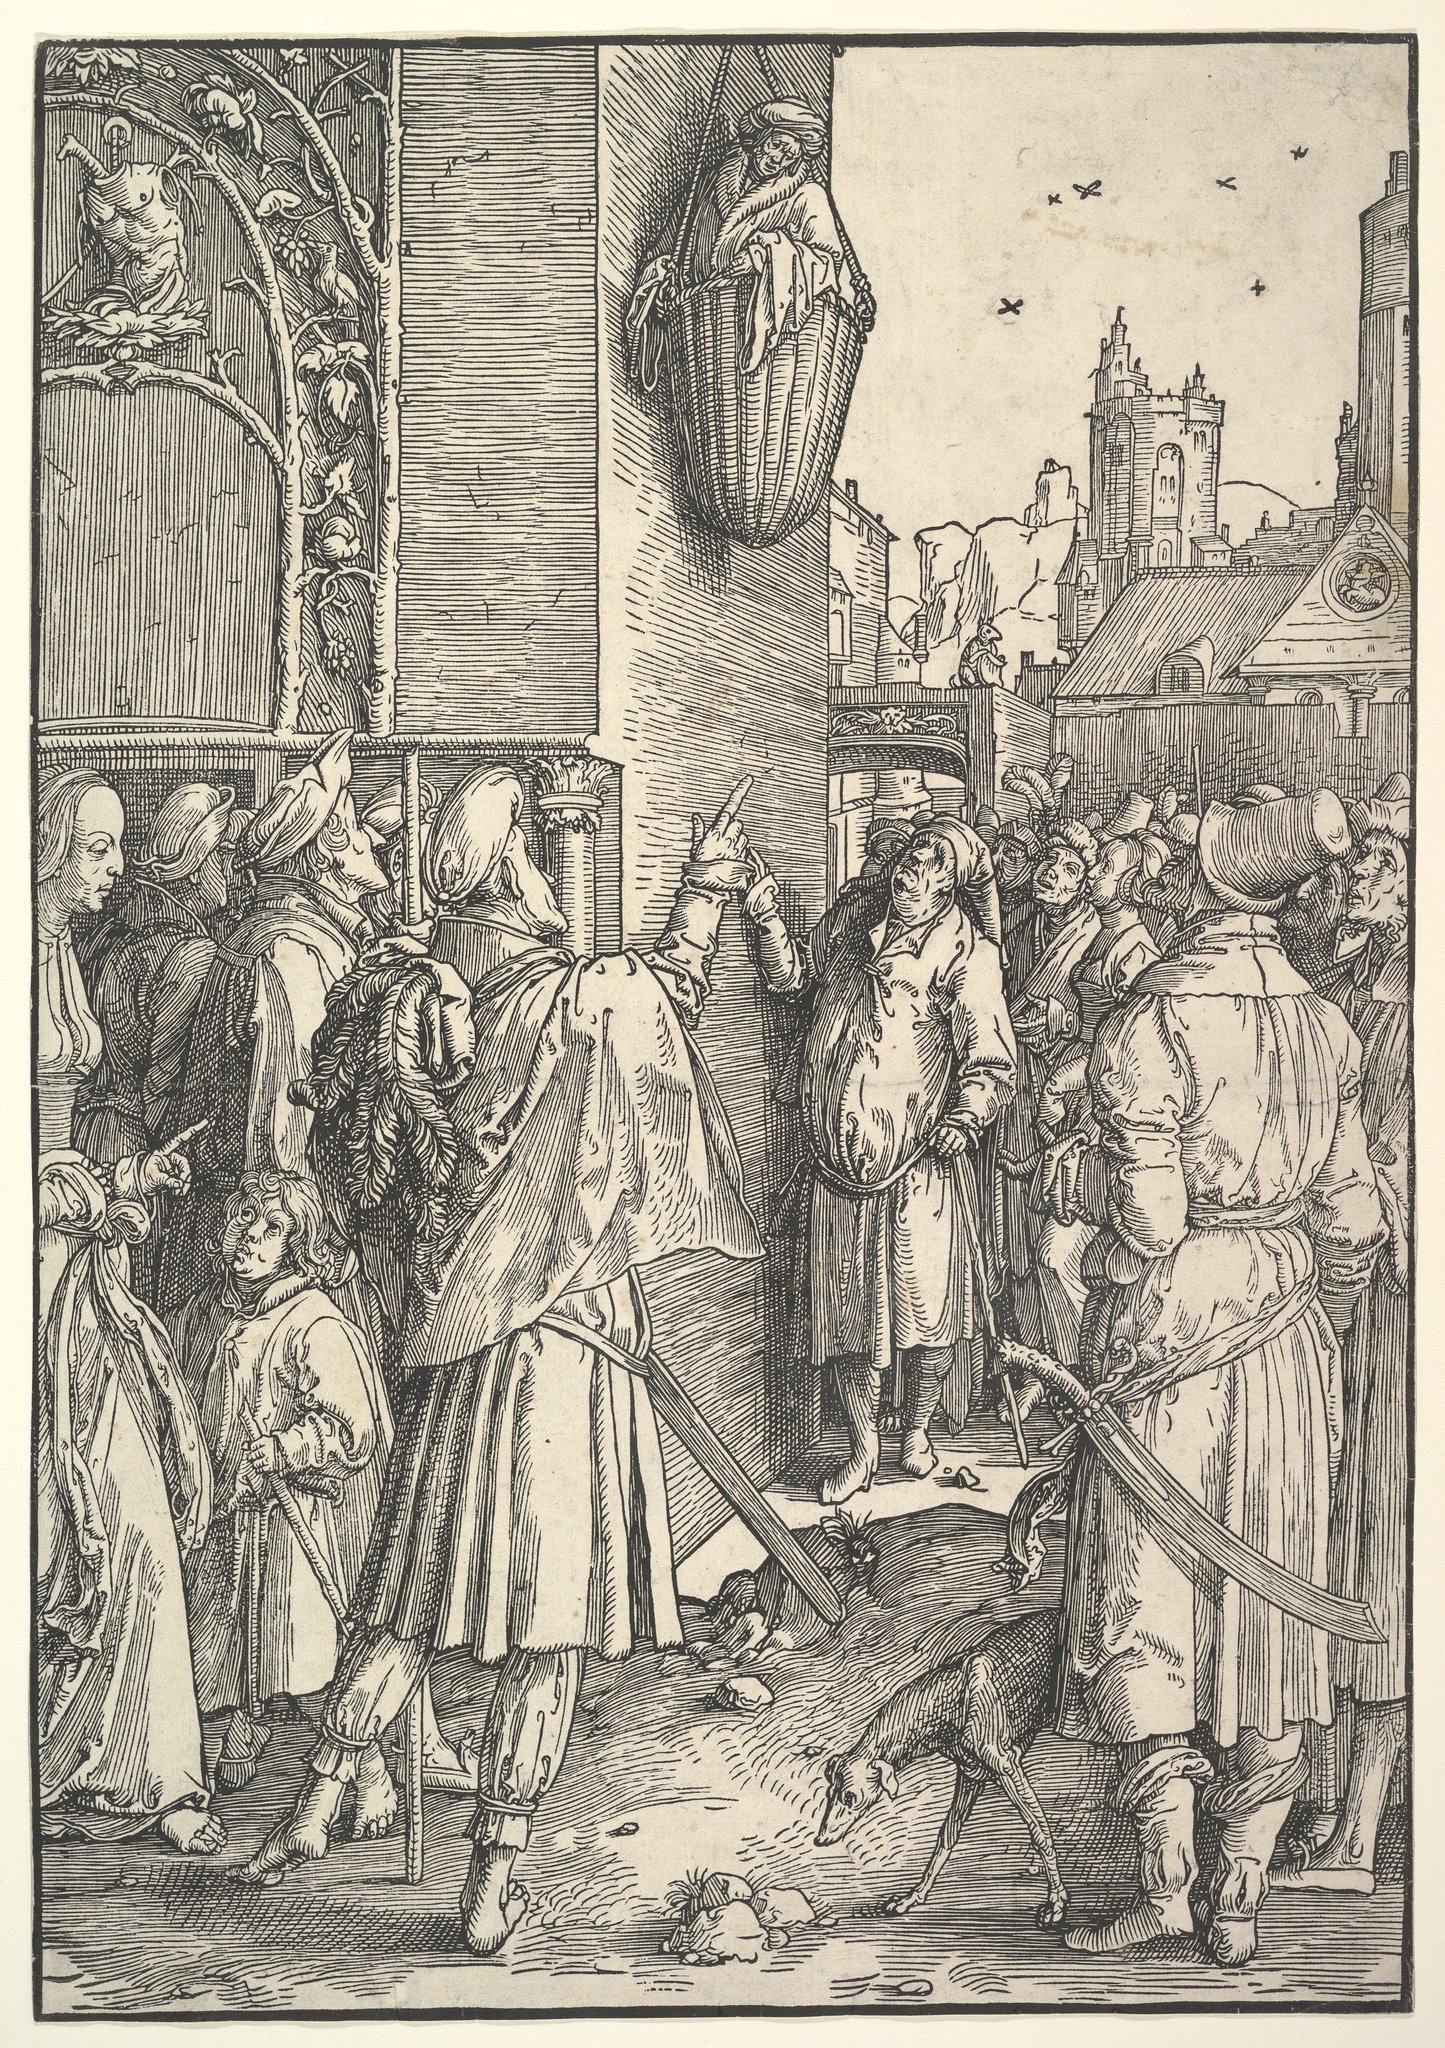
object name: print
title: The Poet Virgil in a Basket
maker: lucas van leyden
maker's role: artist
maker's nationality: netherlandish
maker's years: 1494-1533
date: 1512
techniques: woodcut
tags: buildings,swords,men,dogs,crowd,baskets